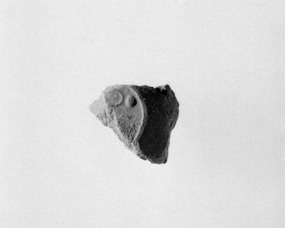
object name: sealing, nebmaatre, amenhotep iii,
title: Document Sealing With the Throne Name of Amenhotep III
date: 1390-1352 BCE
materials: mud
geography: egypt